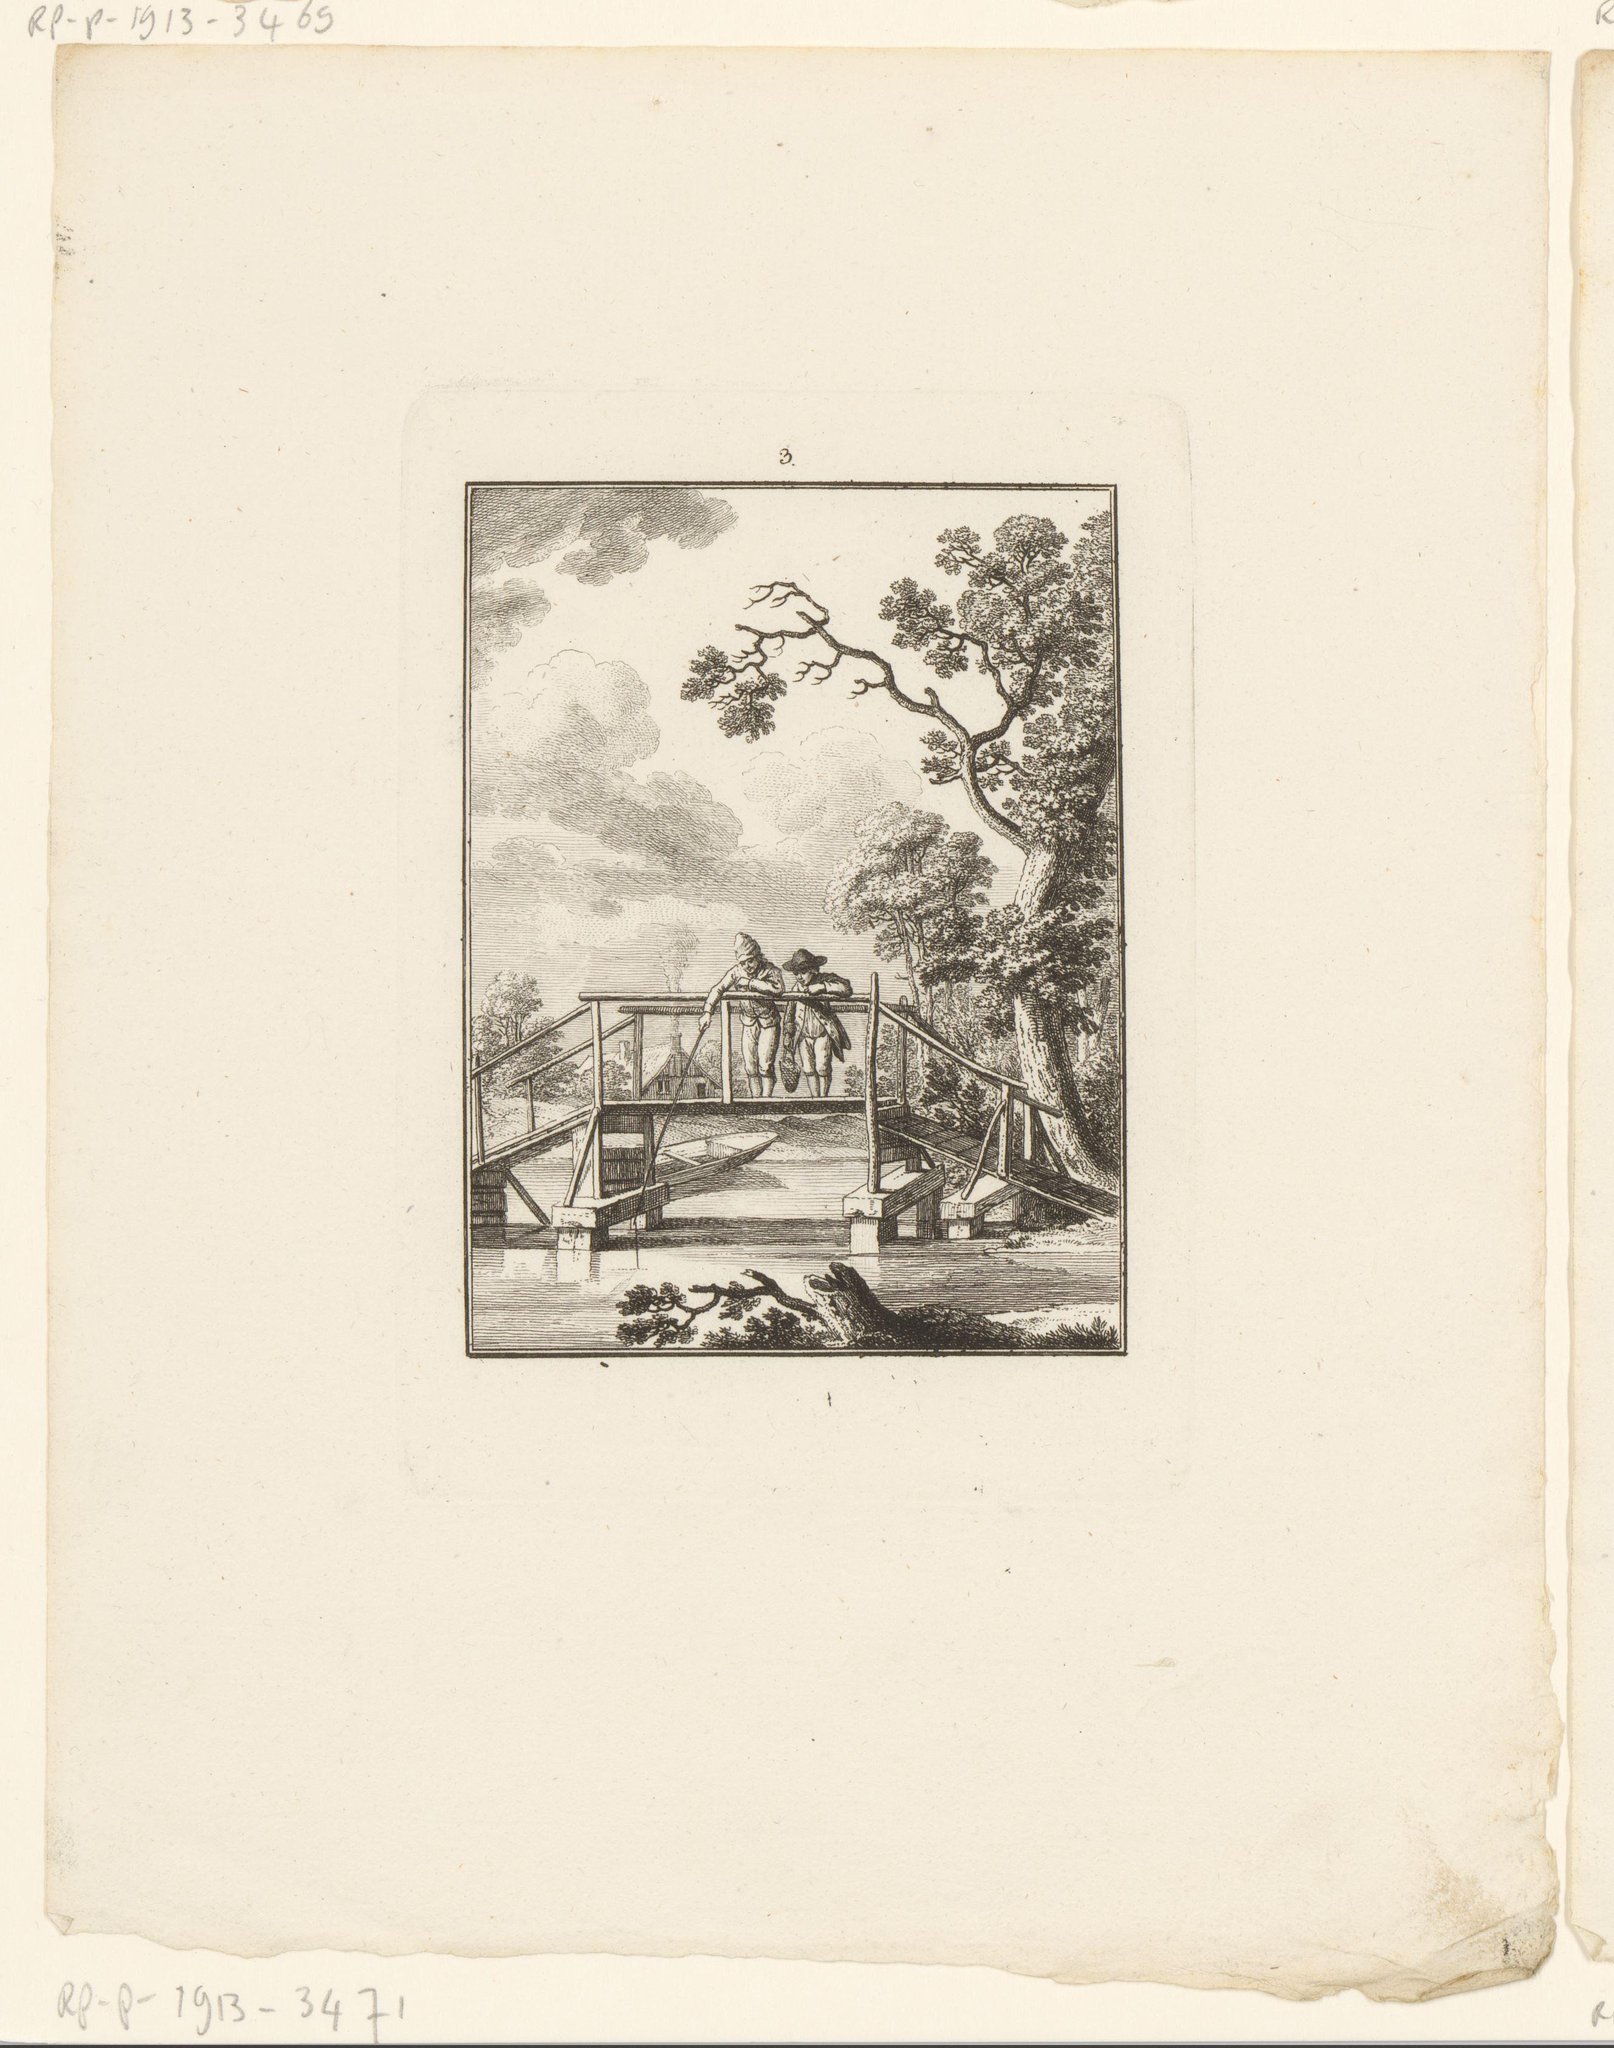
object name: print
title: Landschappen met water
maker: johann rudolph schellenberg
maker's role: print maker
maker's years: 1740-1806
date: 1781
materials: paper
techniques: etching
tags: landscapes with waters, waterscapes, seascapes (in the temperate zone), bridge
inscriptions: collector's mark: Lugt 2228